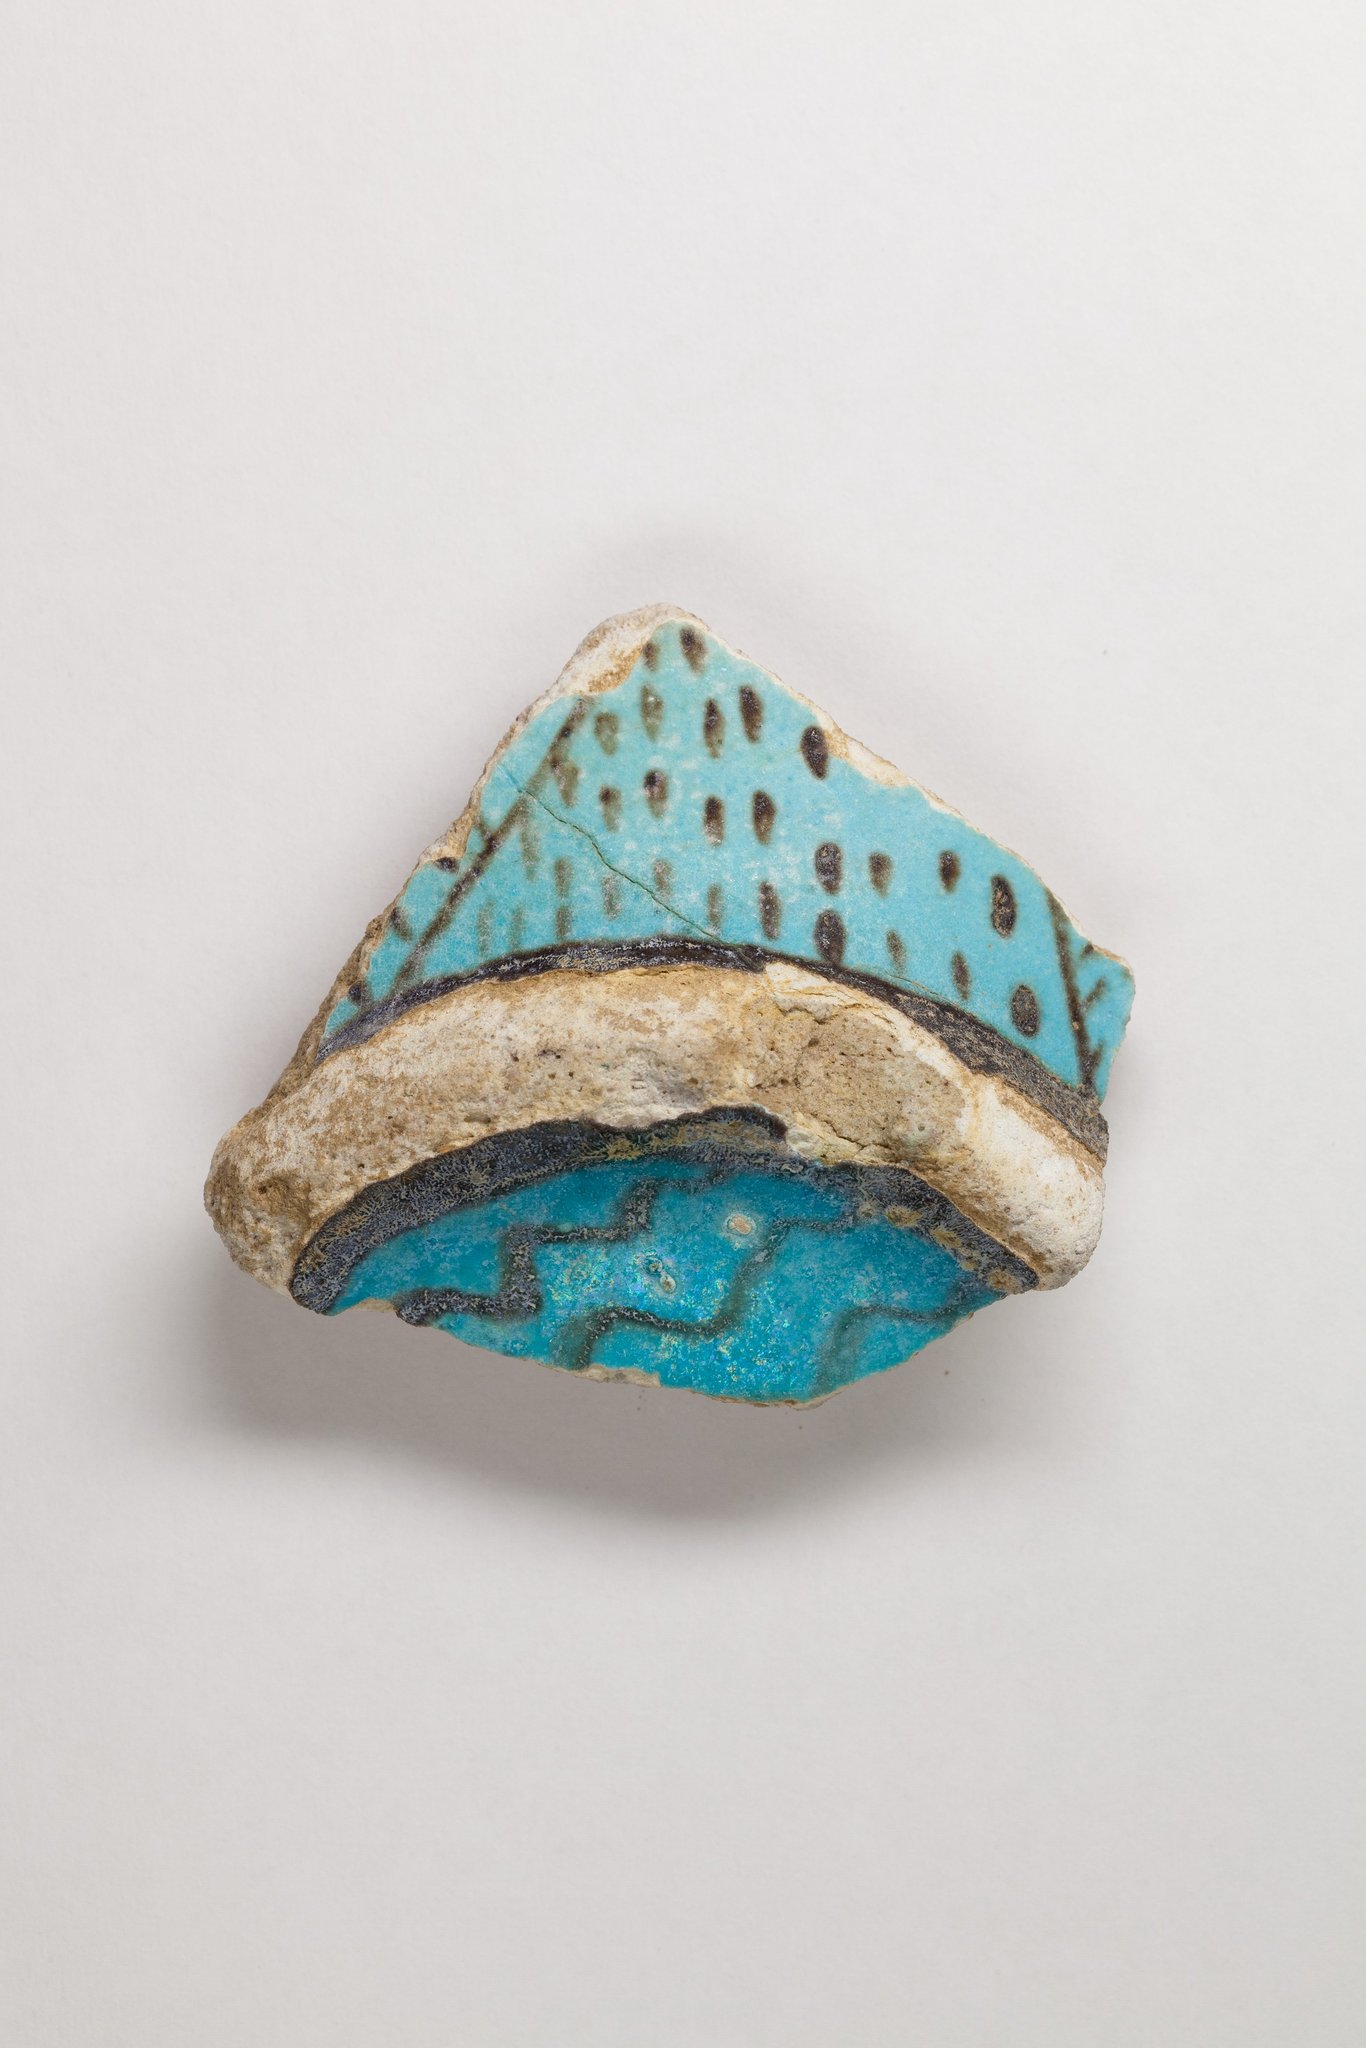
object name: vase fragment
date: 1981-1640 BCE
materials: faience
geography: egypt